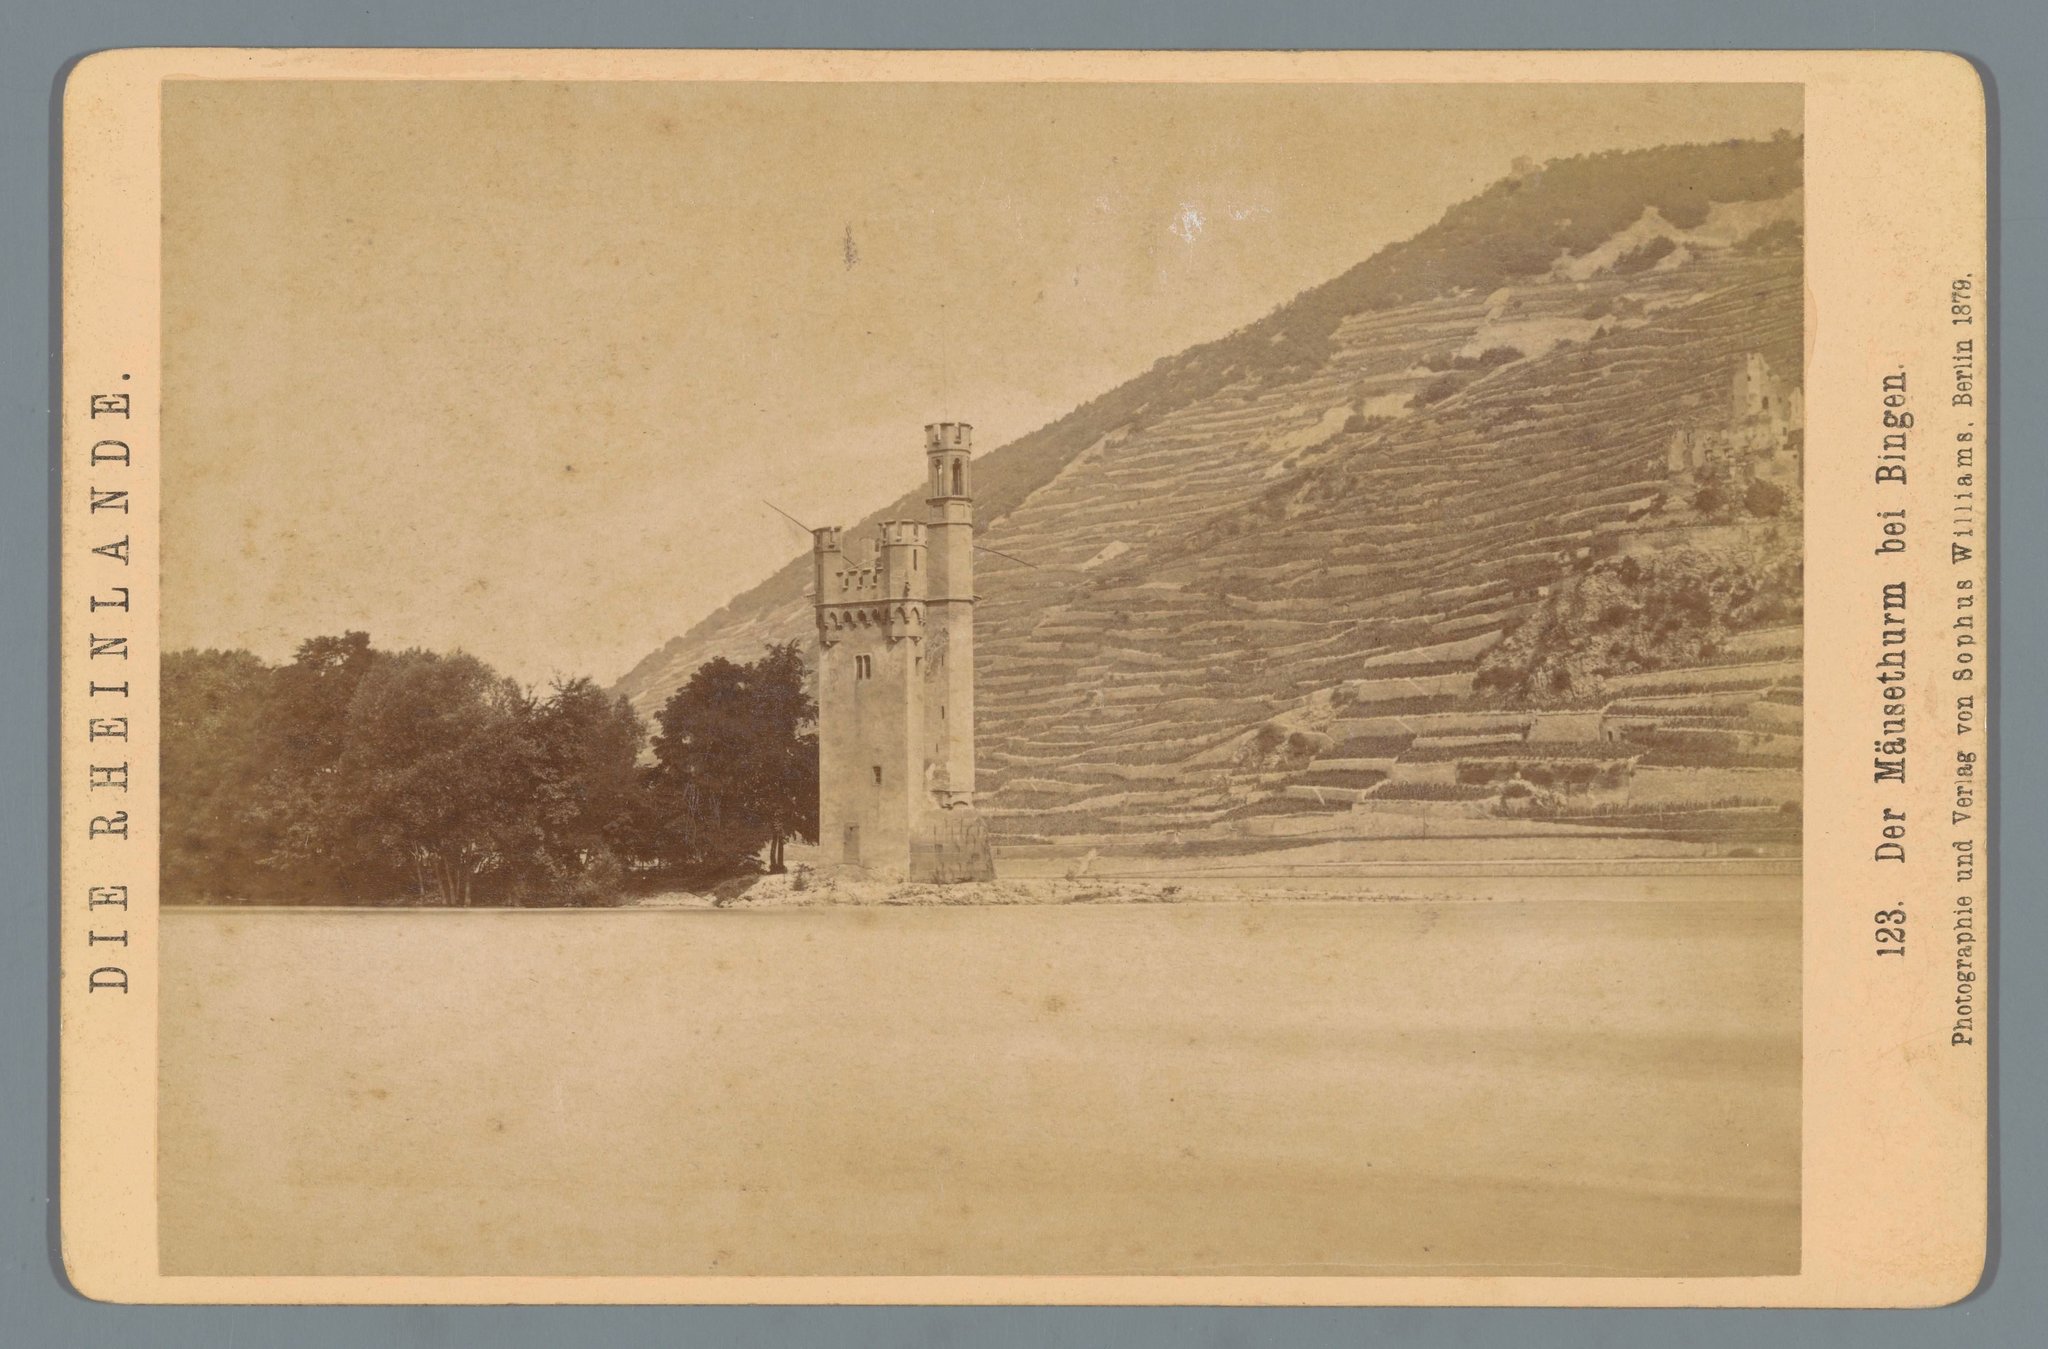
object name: cabinet photograph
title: Der Mäusethurm bei Bingen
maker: sophus williams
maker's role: publisher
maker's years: 1835-1900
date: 1879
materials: cardboard, photographic support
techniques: albumen print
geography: bingen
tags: tower, clock tower ~ monumental adornment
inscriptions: workshop stamp: ‘Photographie und Verlag von Sophus Williams. Berlin 1879.’, number: ‘123.’